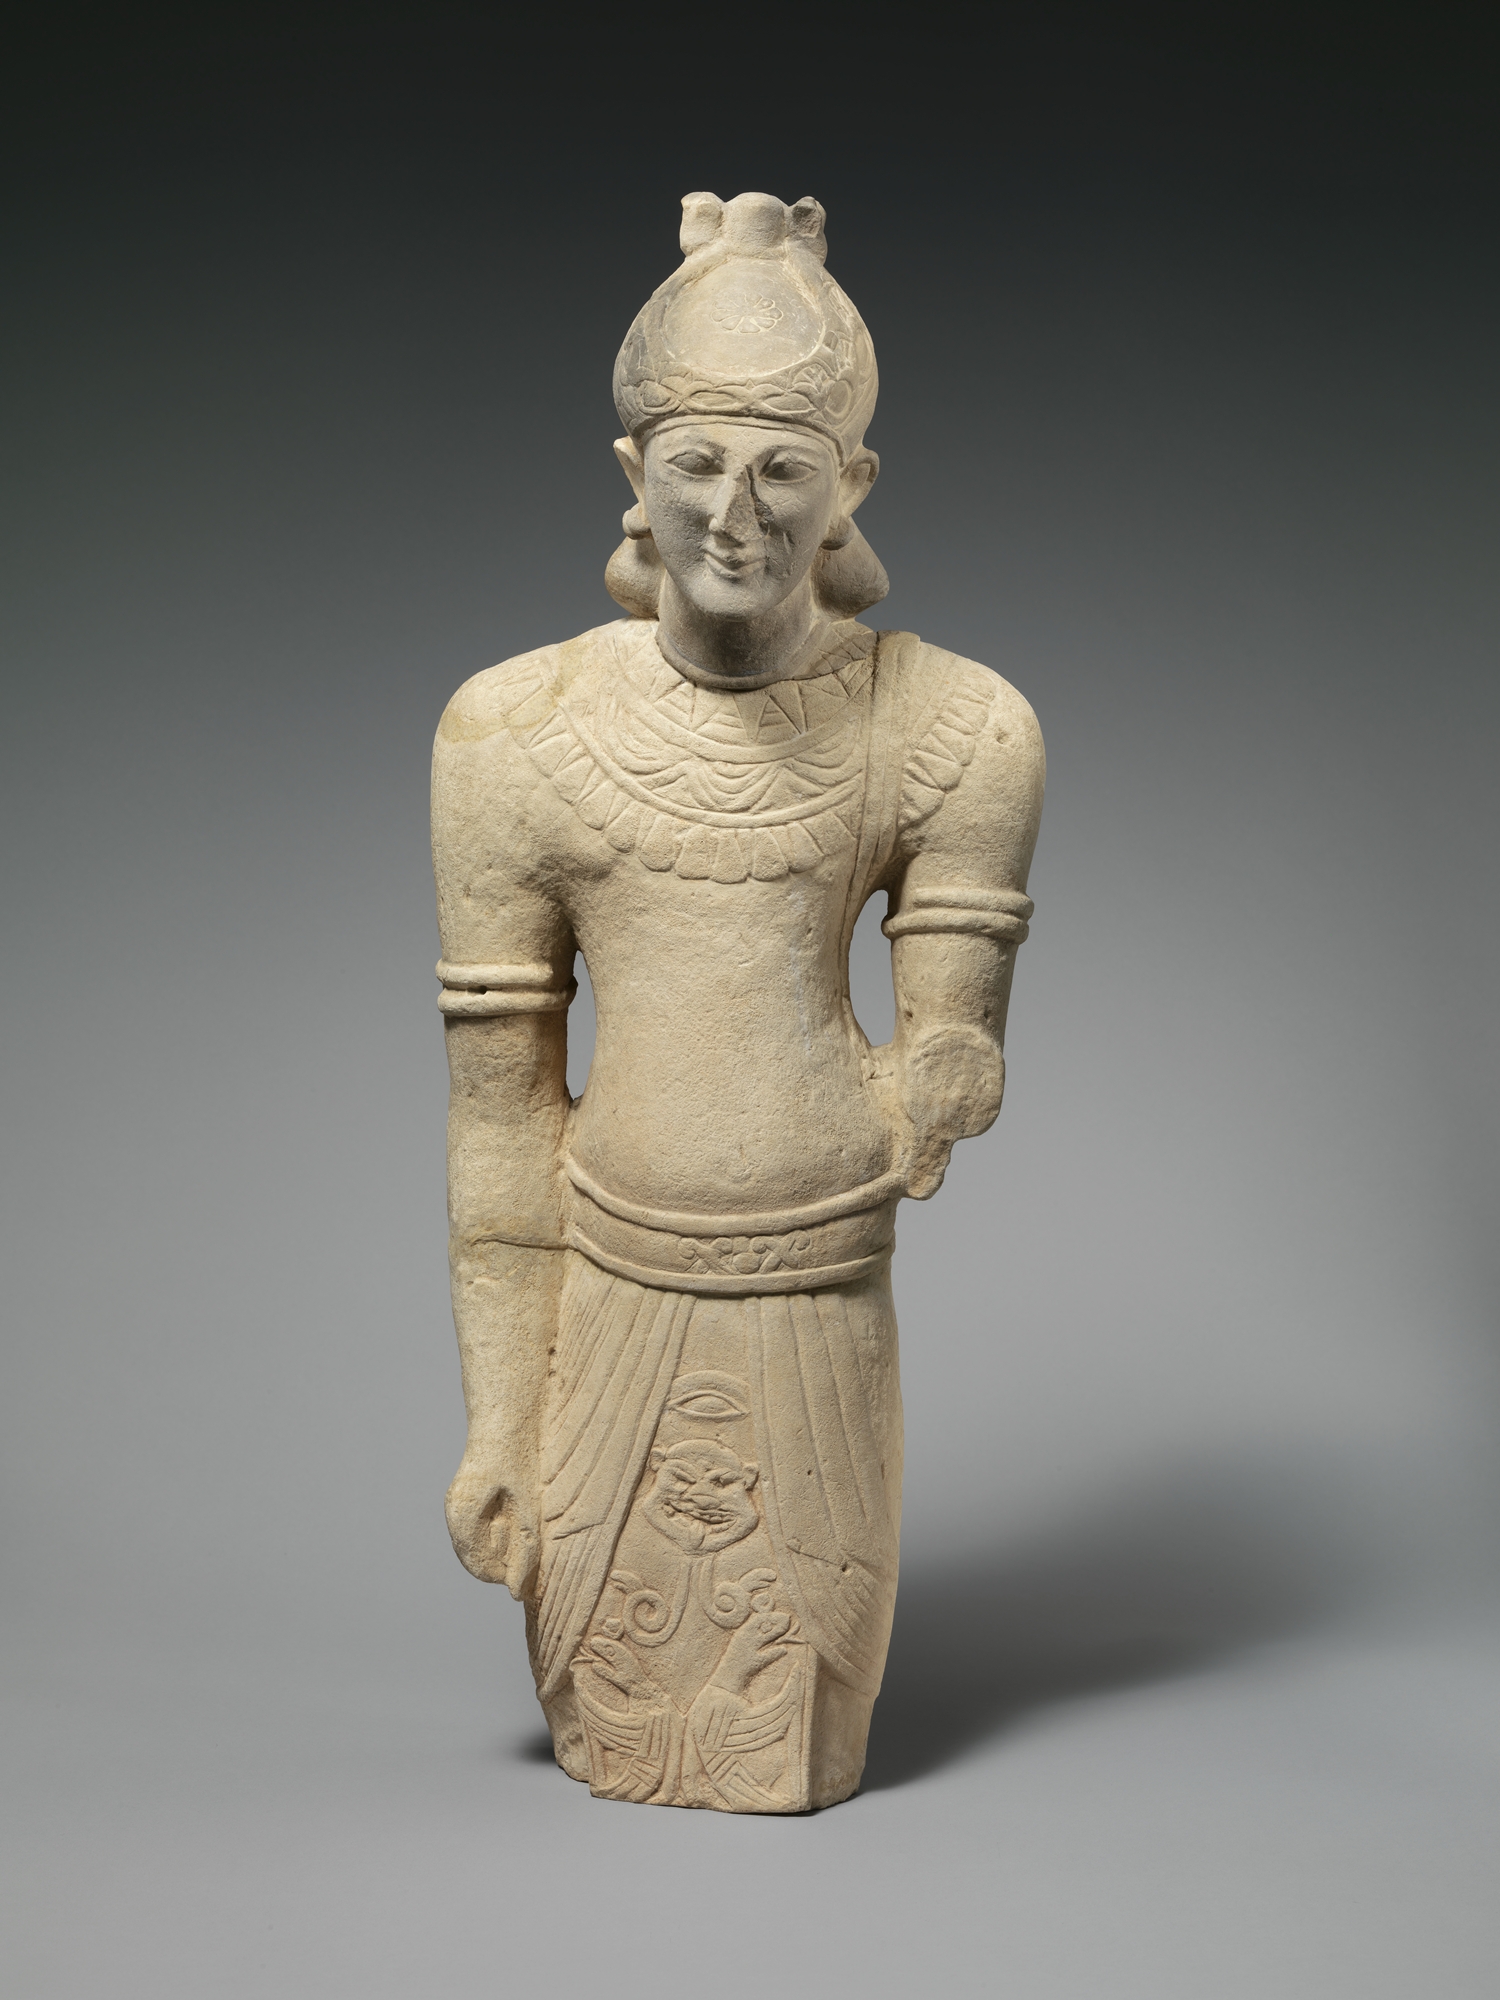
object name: statue of a man in egyptian dress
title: Limestone male figure in Egyptian dress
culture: cypriot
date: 567-535 BCE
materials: limestone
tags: men